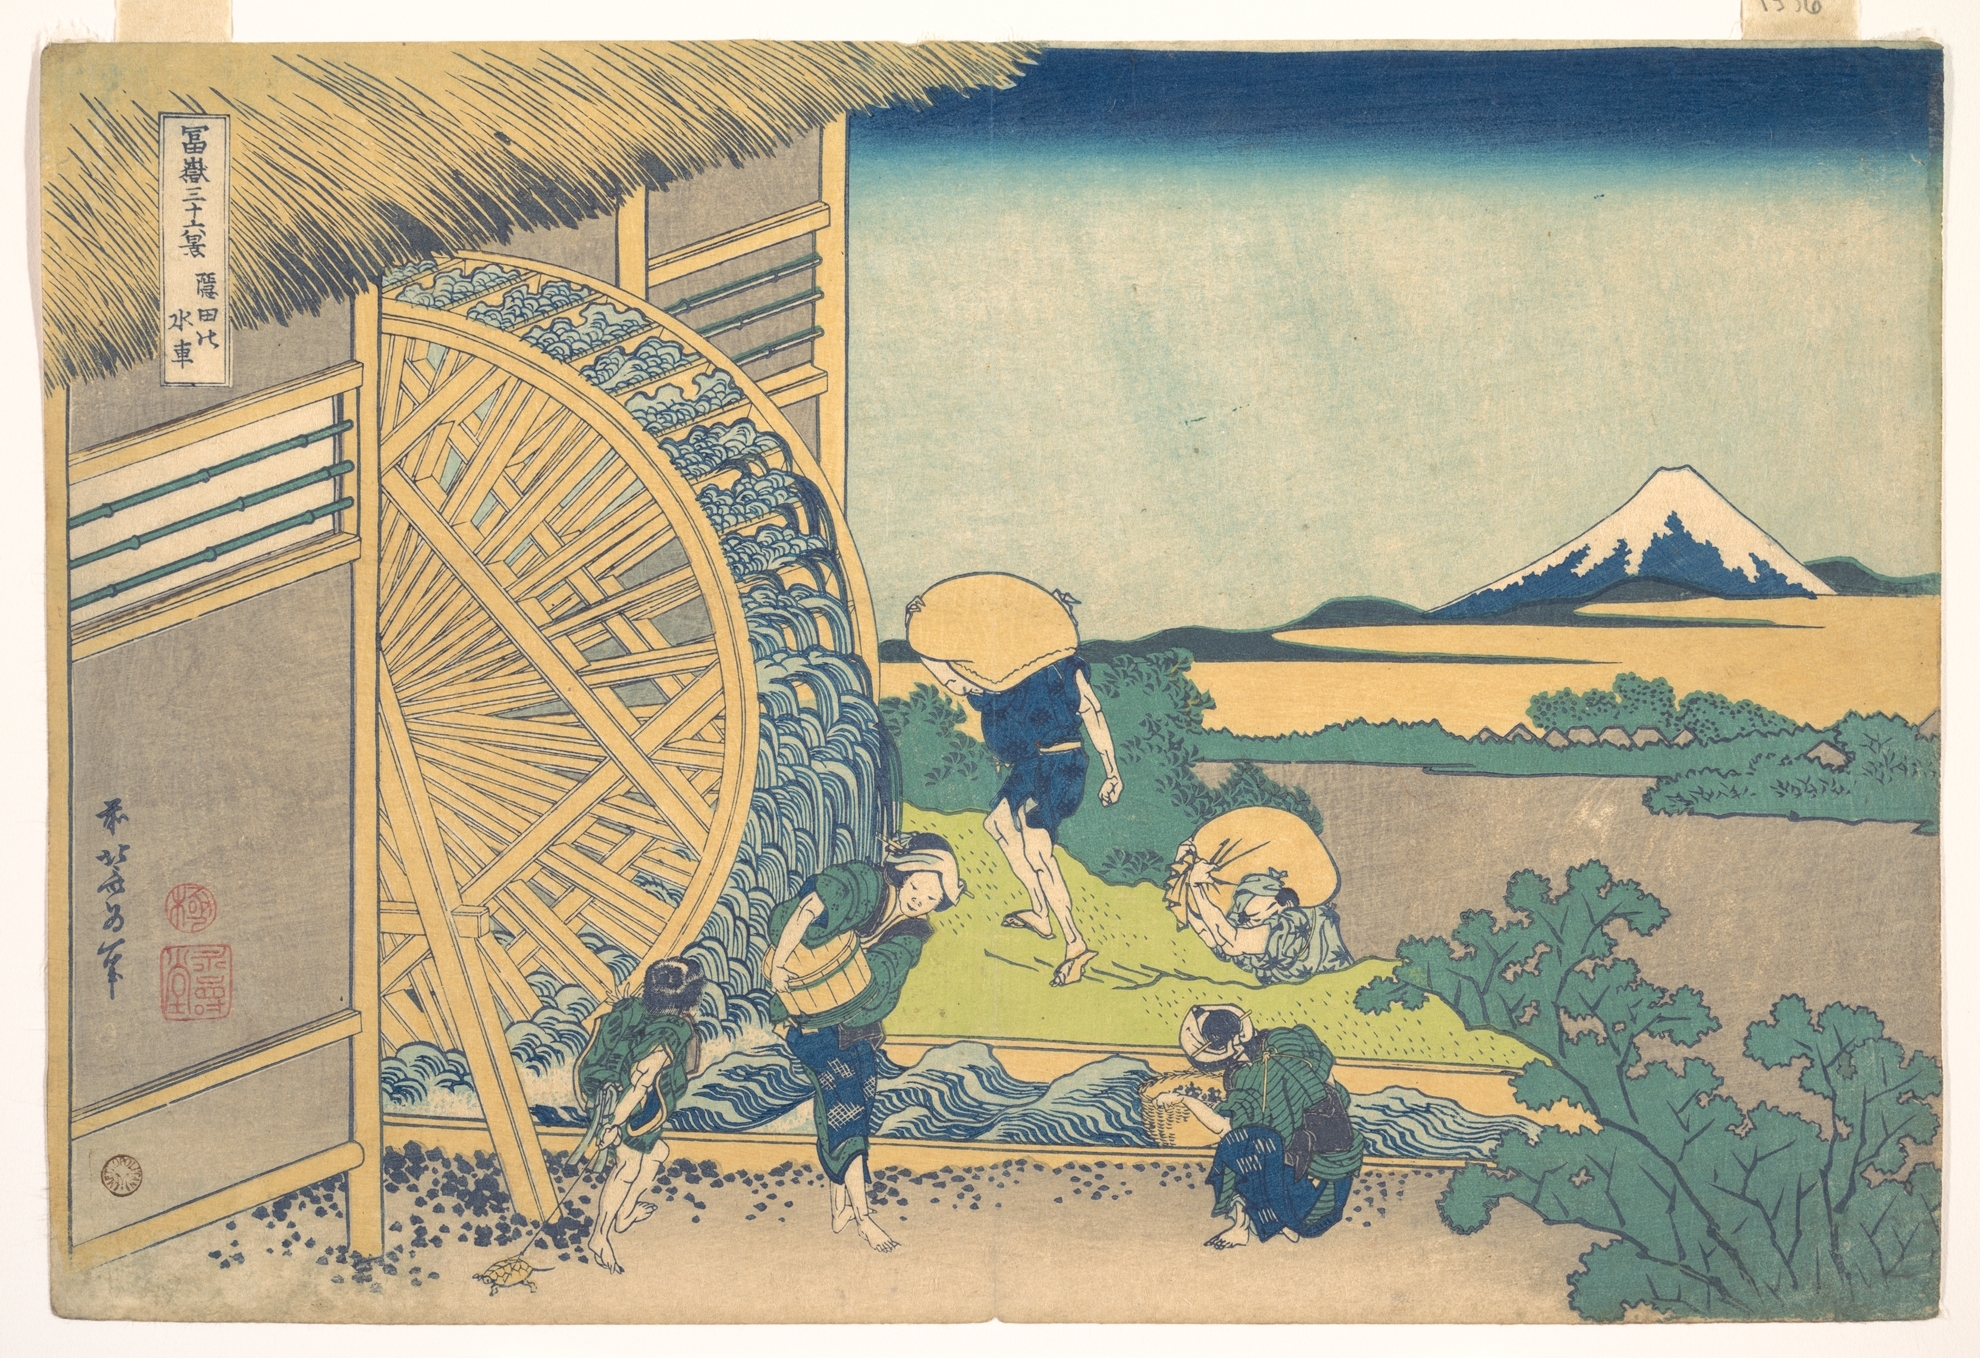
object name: woodblock print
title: The Waterwheel at Onden (Onden no suisha), from the series Thirty-six Views of Mount Fuji (Fugaku sanjūrokkei)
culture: japanese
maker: katsushika hokusai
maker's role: artist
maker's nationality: japanese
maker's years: 1760-1849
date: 1830-1832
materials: ink, paper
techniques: woodblock print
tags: watermills,men,women,mountains